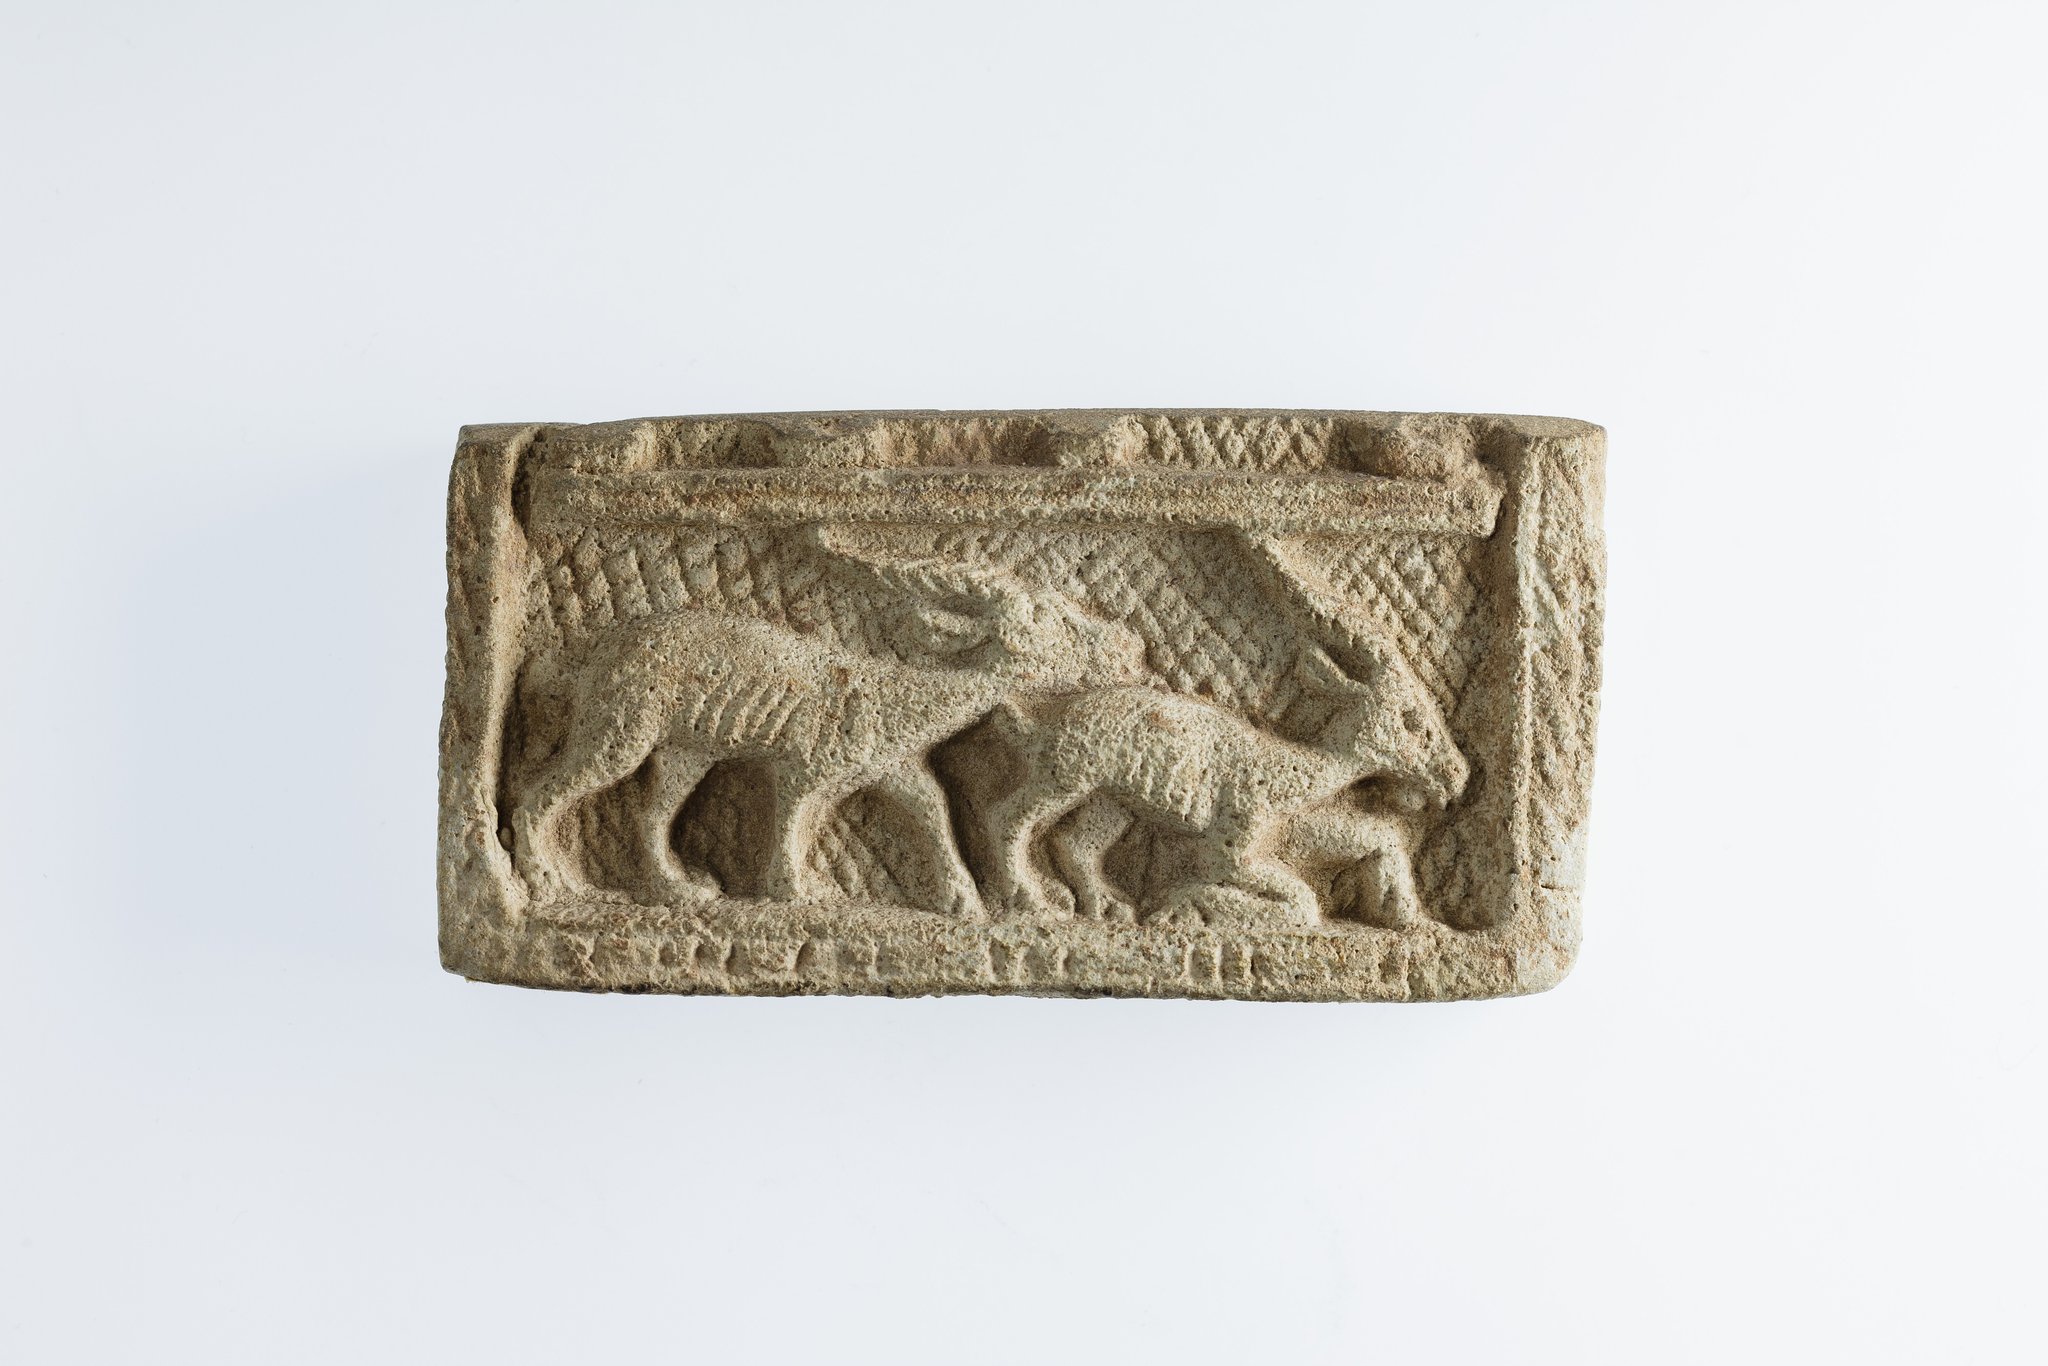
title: Two-Sided Plaque with Gazelles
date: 1550-664 BCE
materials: faience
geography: egypt